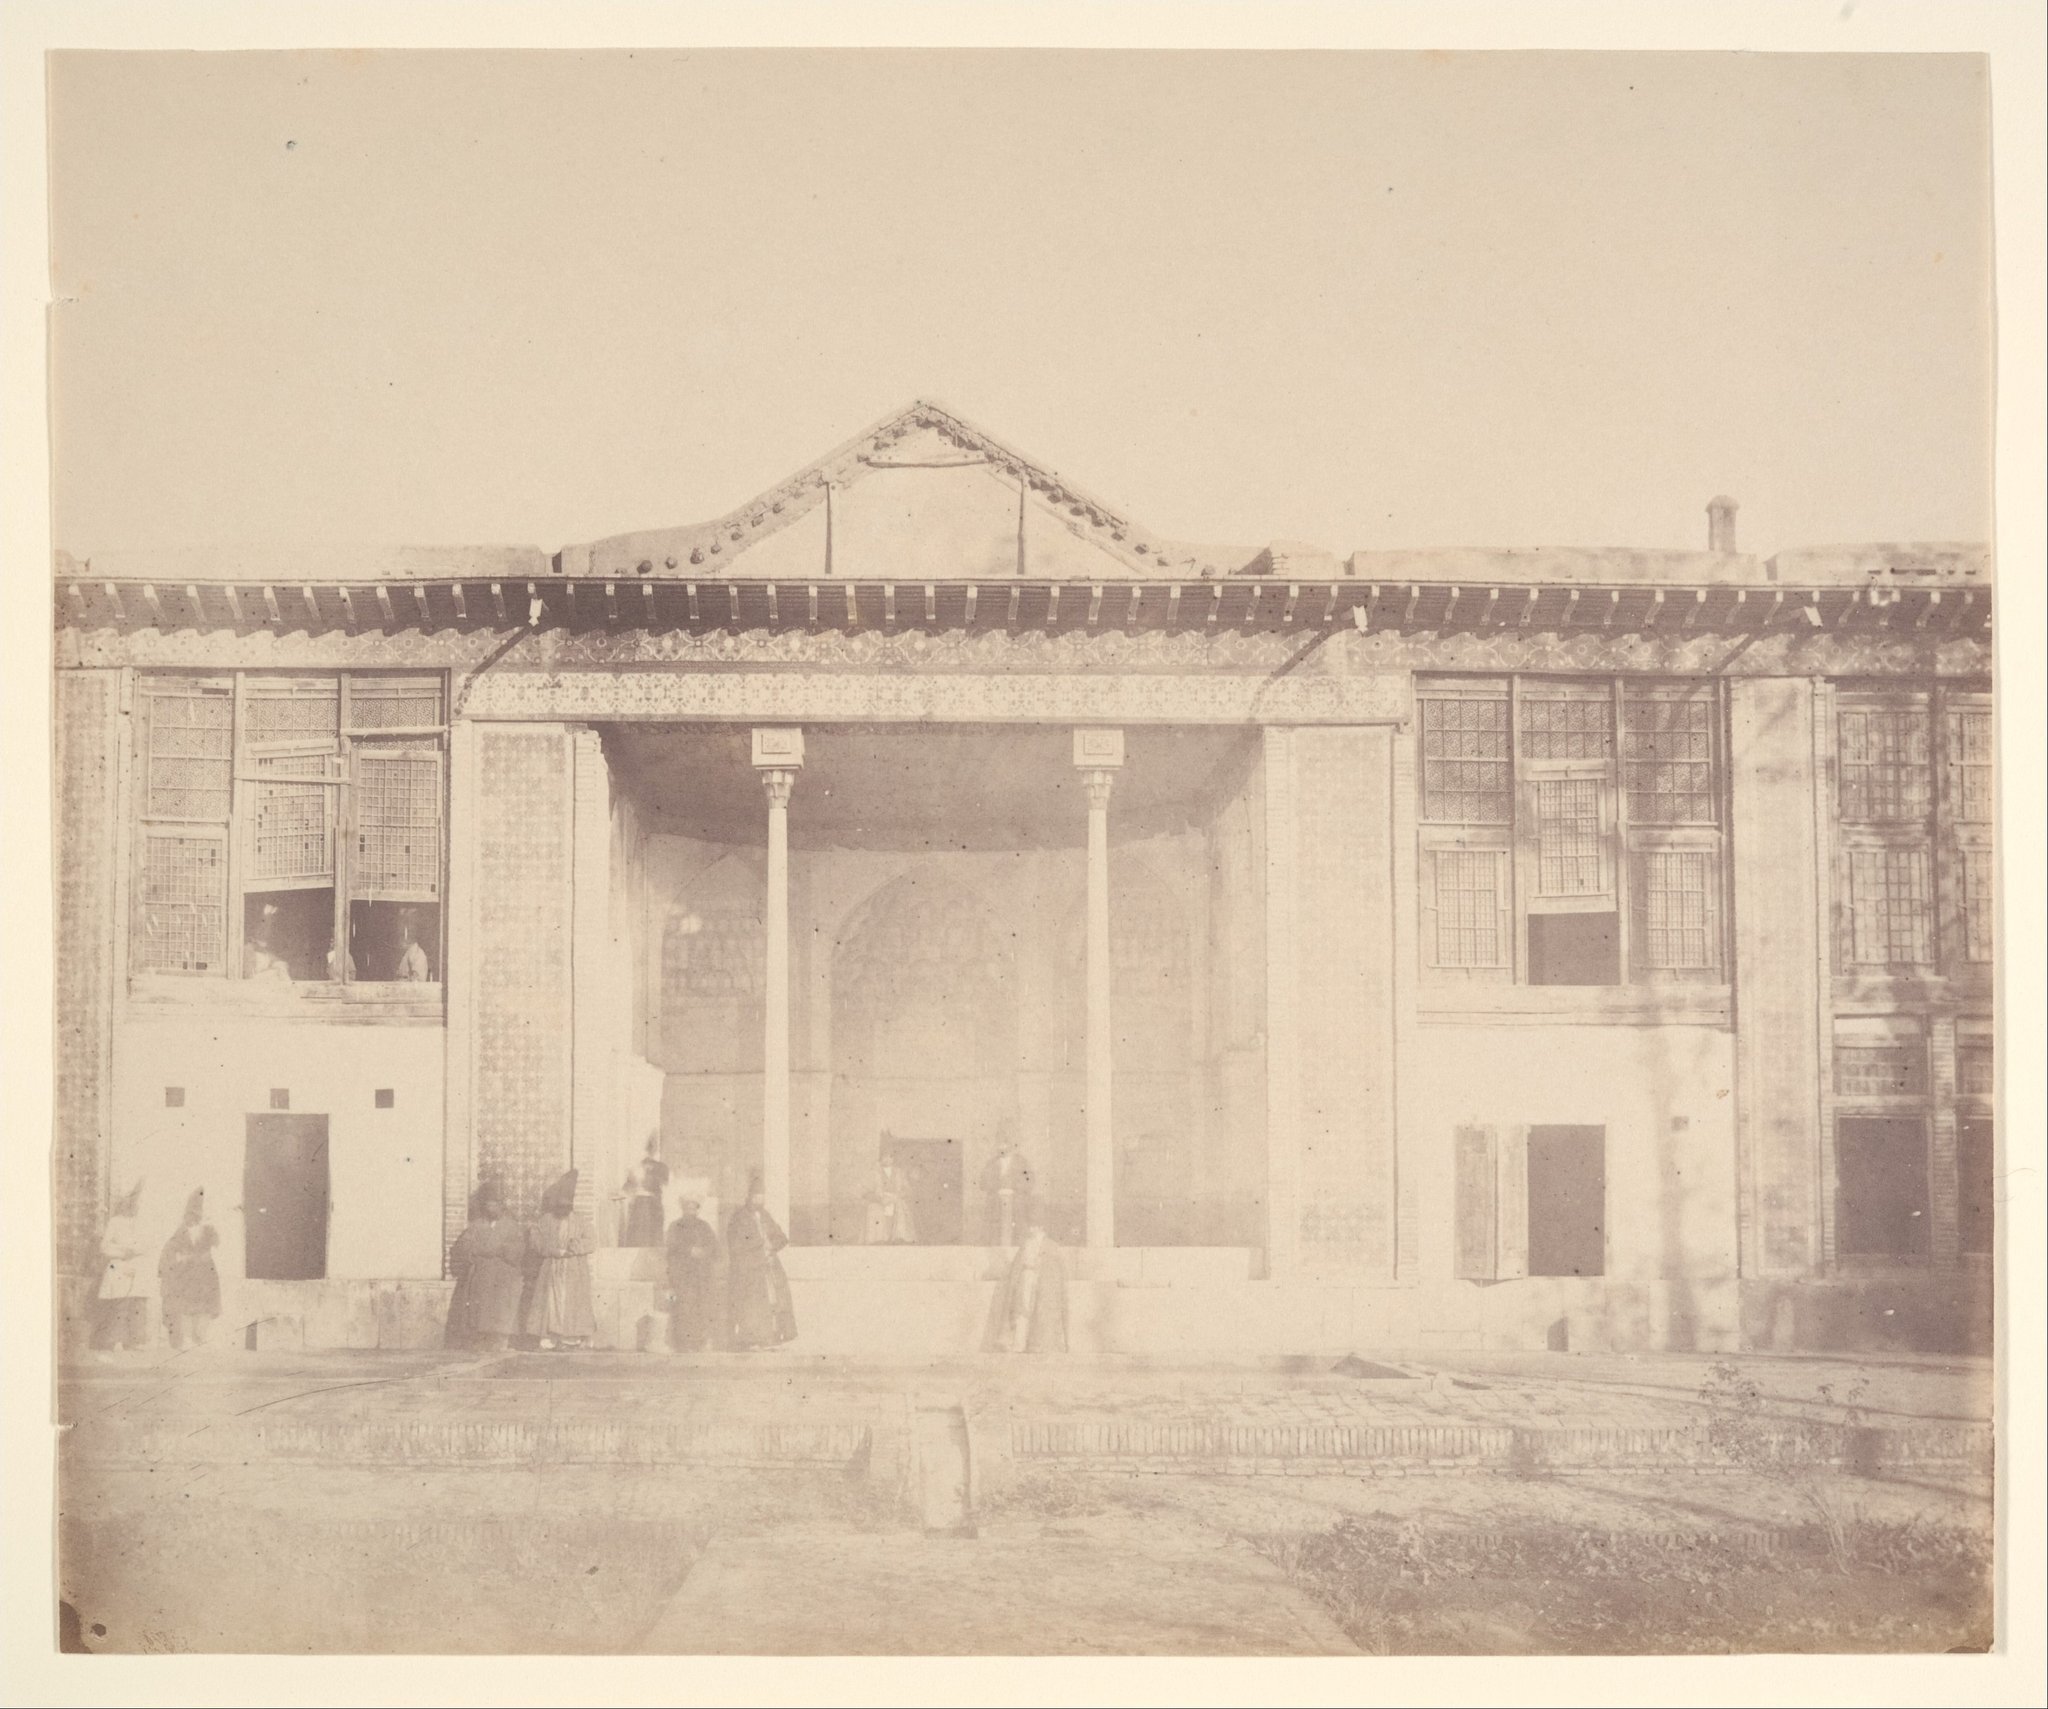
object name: photograph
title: [Palace of the Shah, Teheran, Iran]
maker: luigi pesce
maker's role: artist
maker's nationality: italian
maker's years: 1818-1891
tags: architecture,palaces